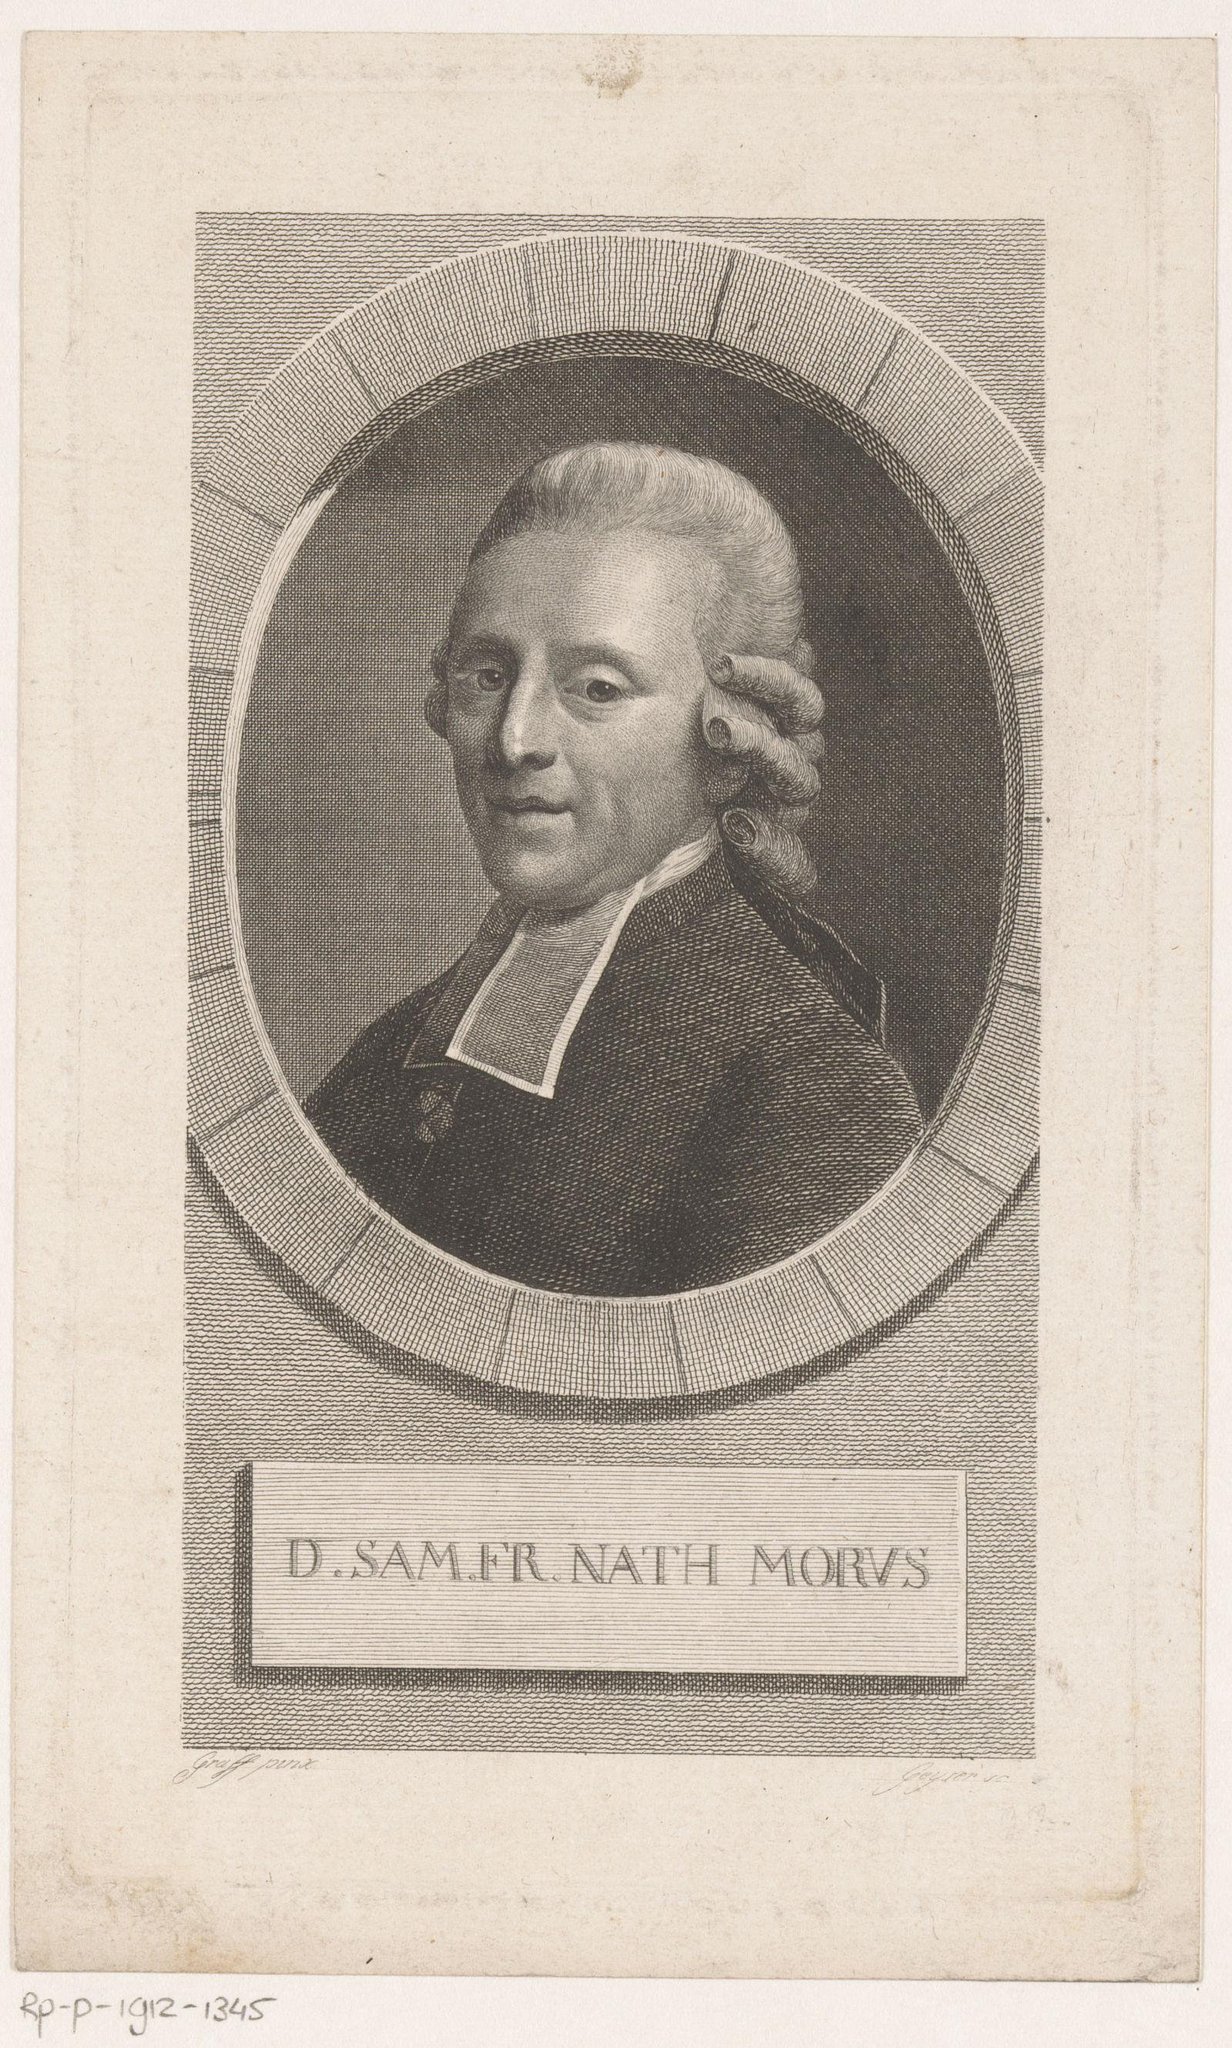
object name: print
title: Portret van Samuel Friedrich Nathanael Morus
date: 1752-1792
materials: paper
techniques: engraving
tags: historical persons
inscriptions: collector's mark: Lugt 2228